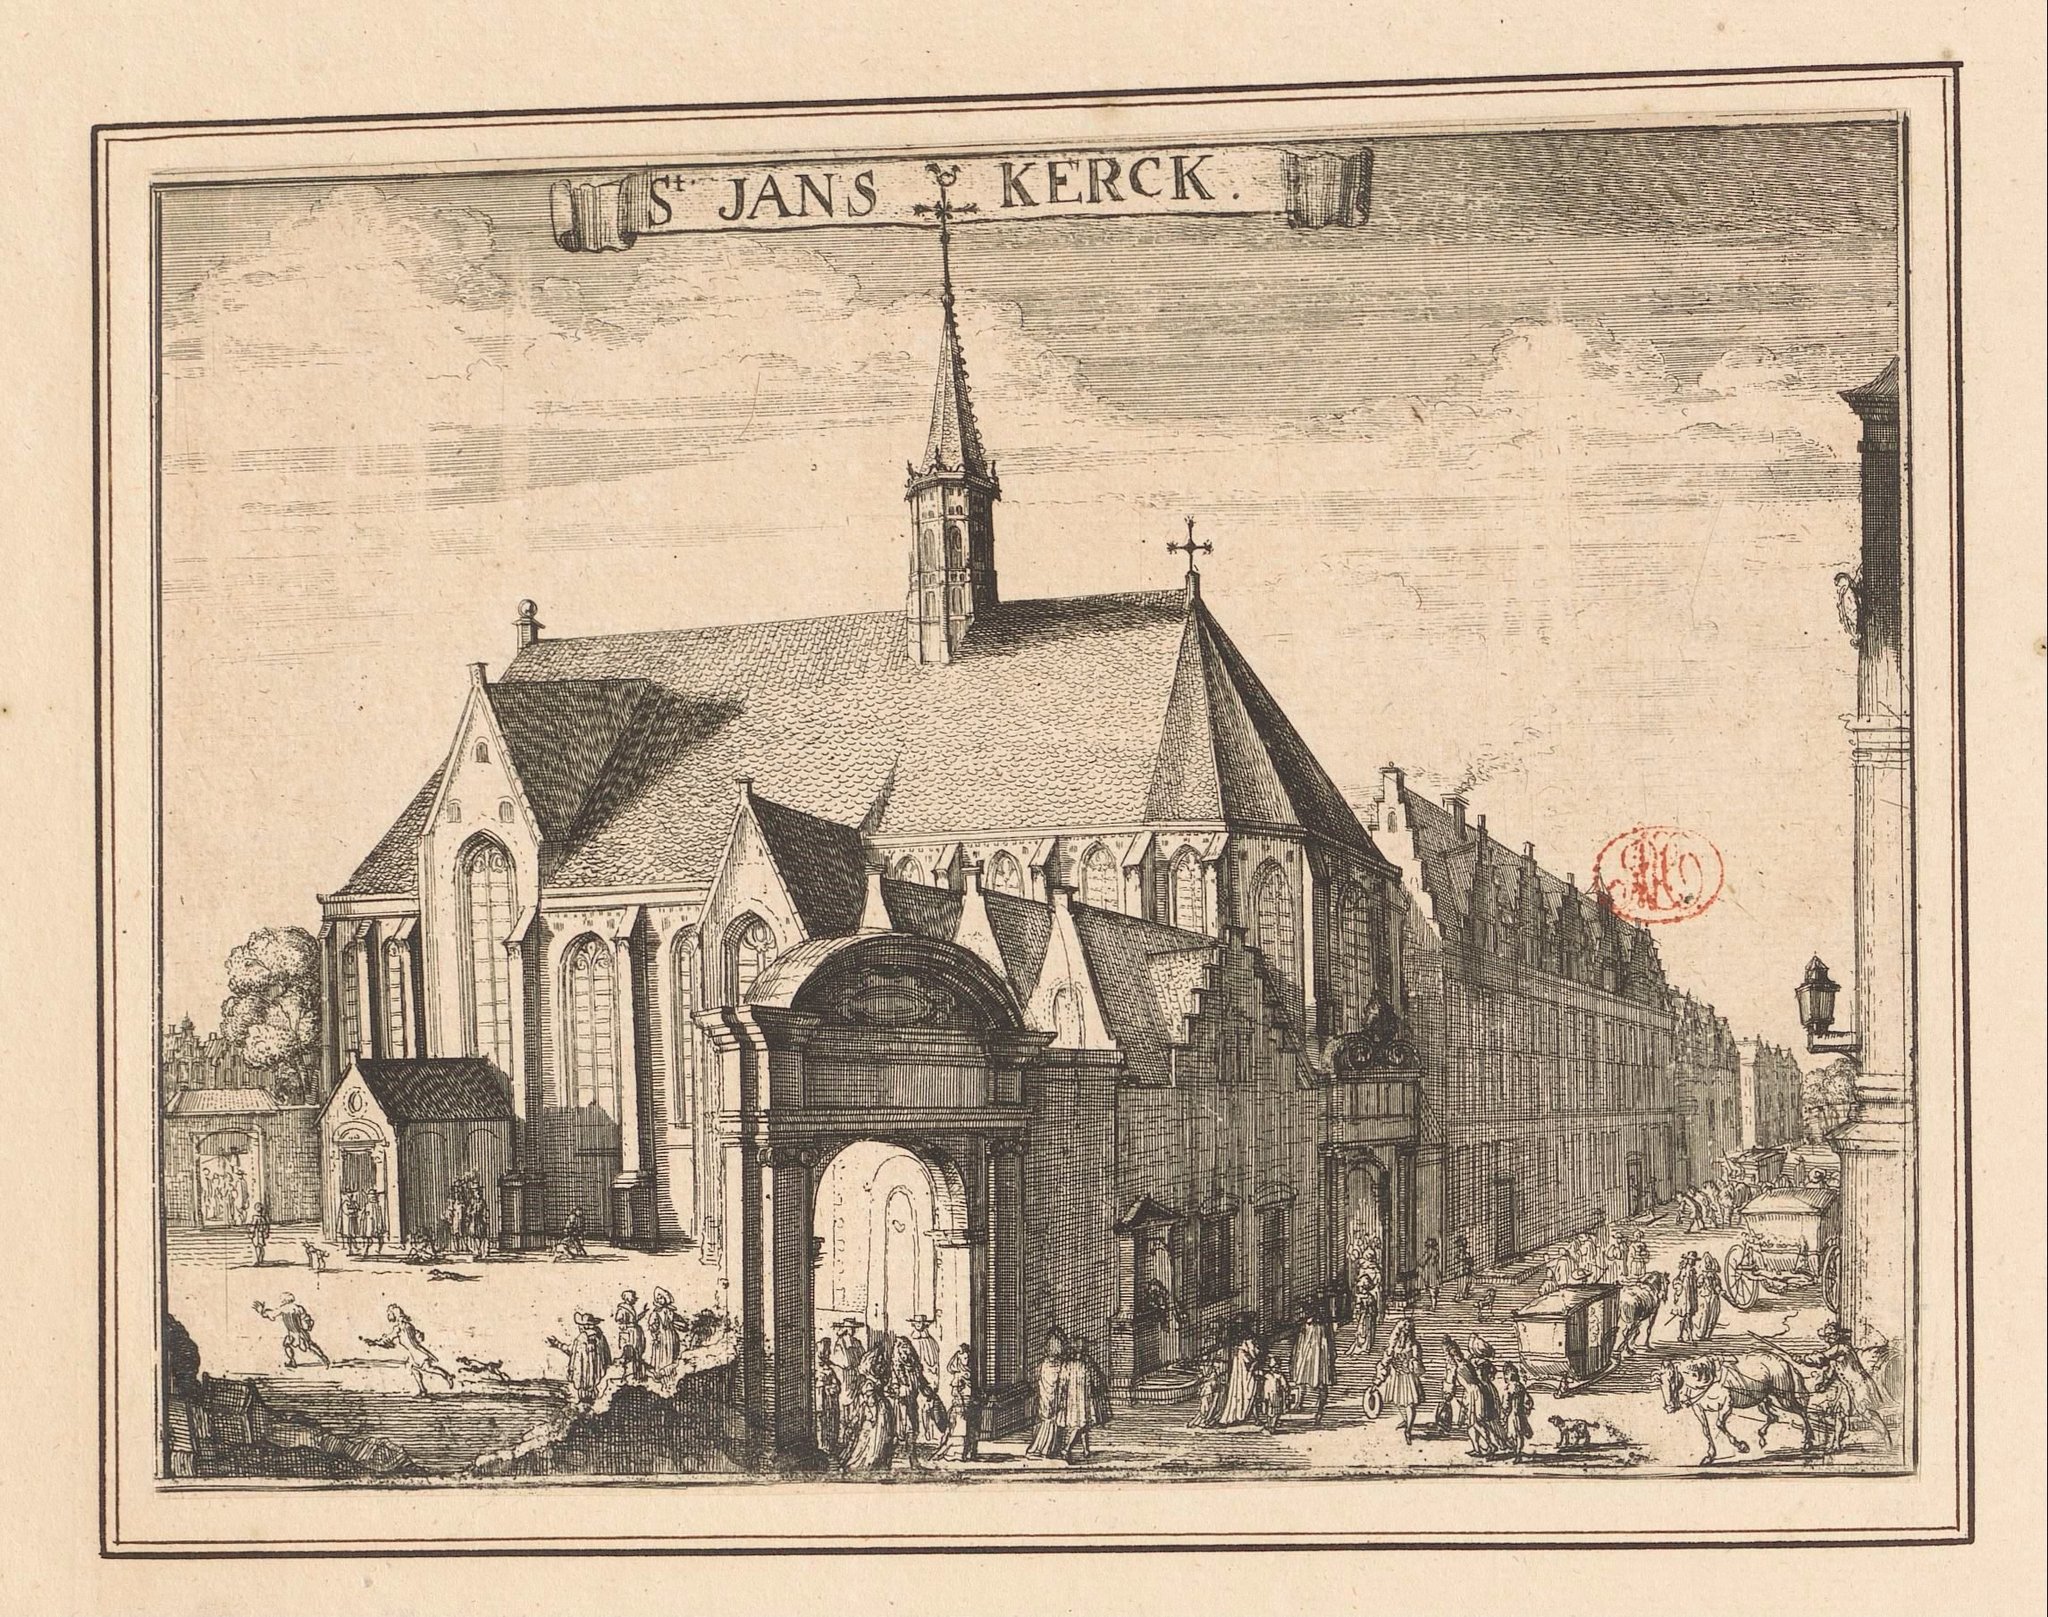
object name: print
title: St. Jans Kerck.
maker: romeyn de hooghe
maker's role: draughtsman, goldsmith, painter, print maker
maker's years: 1645-1708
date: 1688-1689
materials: paper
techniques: etching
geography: haarlem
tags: church (exterior)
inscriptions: collector's mark: Lugt 195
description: Gezicht op de Janskerk te Haarlem, met vele mensen en enkele koetsen in de straat ervoor en op het plaatsje ernaast. Dit blad maakt deel uit van een omvangrijke prent met een grote plattegrond van Haarlem, omgeven door zeven wapenschilden, een profiel van de stad, gezichten op markante Haarlemse gebouwen en voorstellingen van belangrijke momenten uit de Haarlemse geschiedenis.